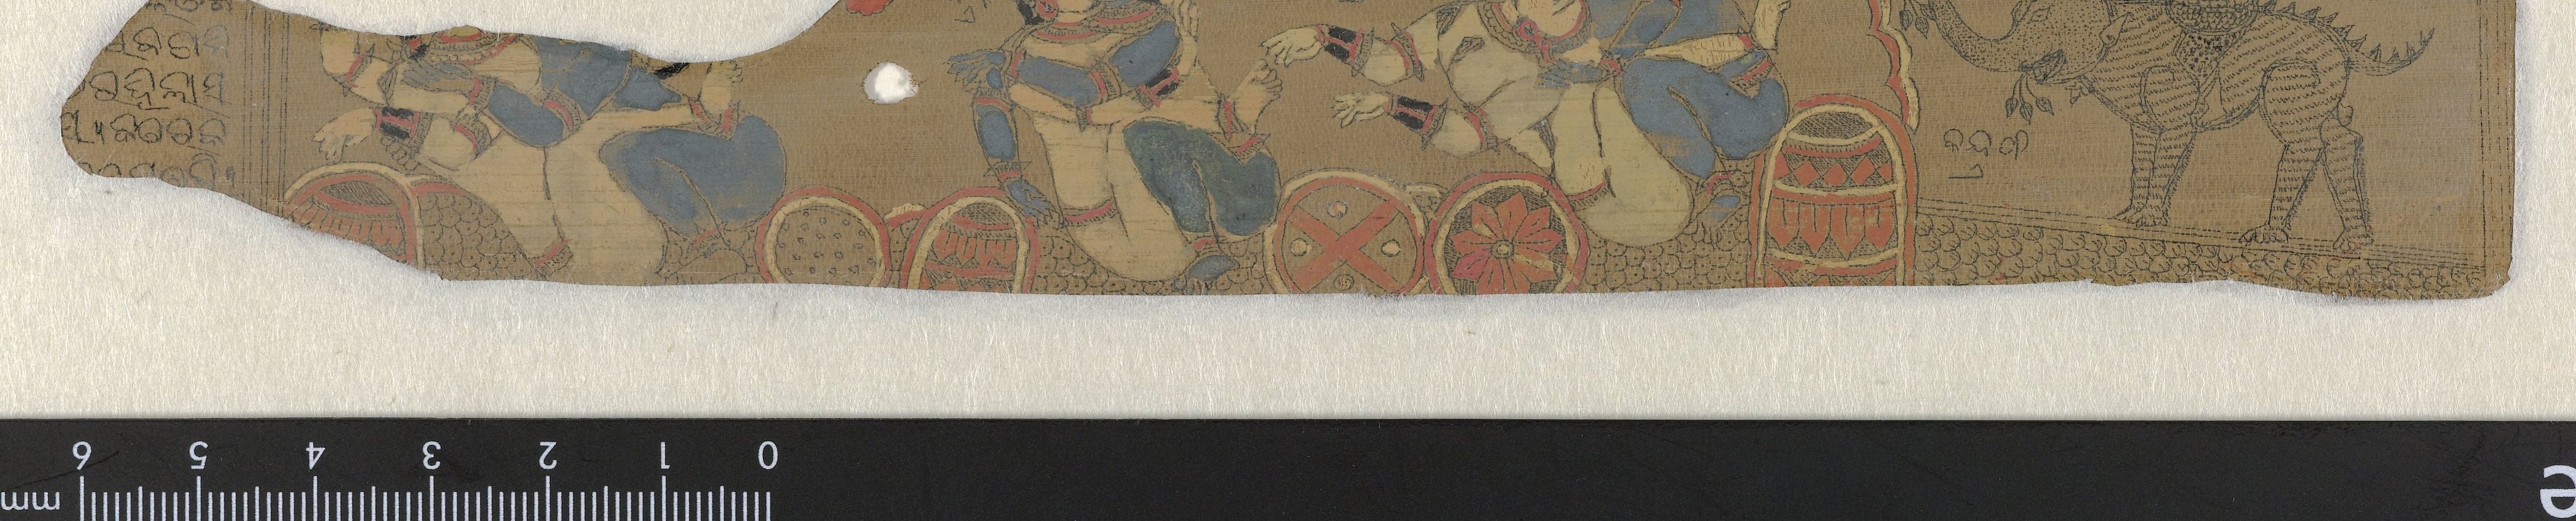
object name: drawing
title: Erotische scènes van Krishna en Radha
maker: Anonymous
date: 1700-1800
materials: leaf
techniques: brush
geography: odisha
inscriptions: inscription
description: De versokant is ondersteboven beschilderd met erotische taferelen van Krishna en Radha in een paneel dat het grootste deel van het blad beslaat, links is nog een klein stukje oud-Indiaas schrift te zien; rechts een ruiter met een lotuspijl en boog op een olifant met gehoornde rug (penseel in zwarte omtreklijnen). Het stukje palmblad is in een blauw passepartout opgenomen zodat voor- en achterkant zichtbaar zijn.